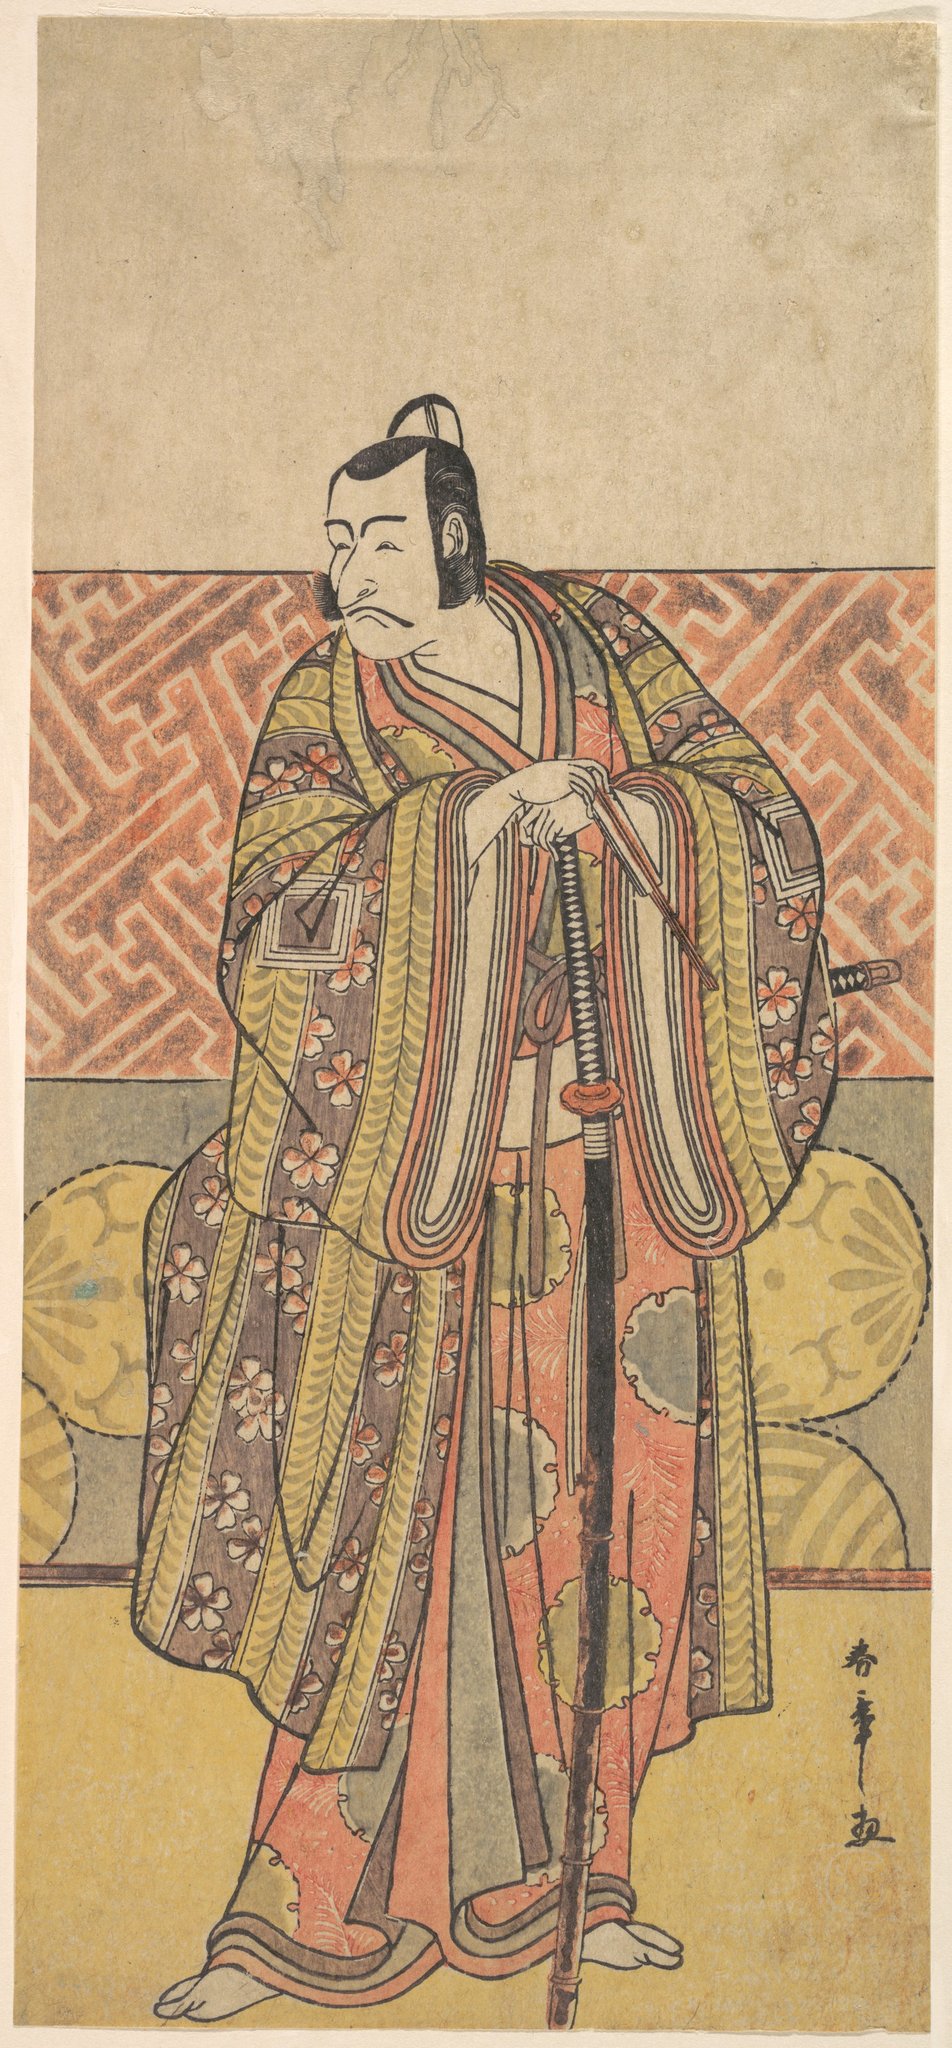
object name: woodblock print nishiki e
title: Ichikawa Danjuro V as Kudo Suketsune, Richly Attired, Leaning on His Sword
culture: japanese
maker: katsukawa shunshō 勝川春章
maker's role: artist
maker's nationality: japanese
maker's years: 1726-1792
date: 1615-1868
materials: ink, paper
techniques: nishiki e, woodblock print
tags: swords,men,actors